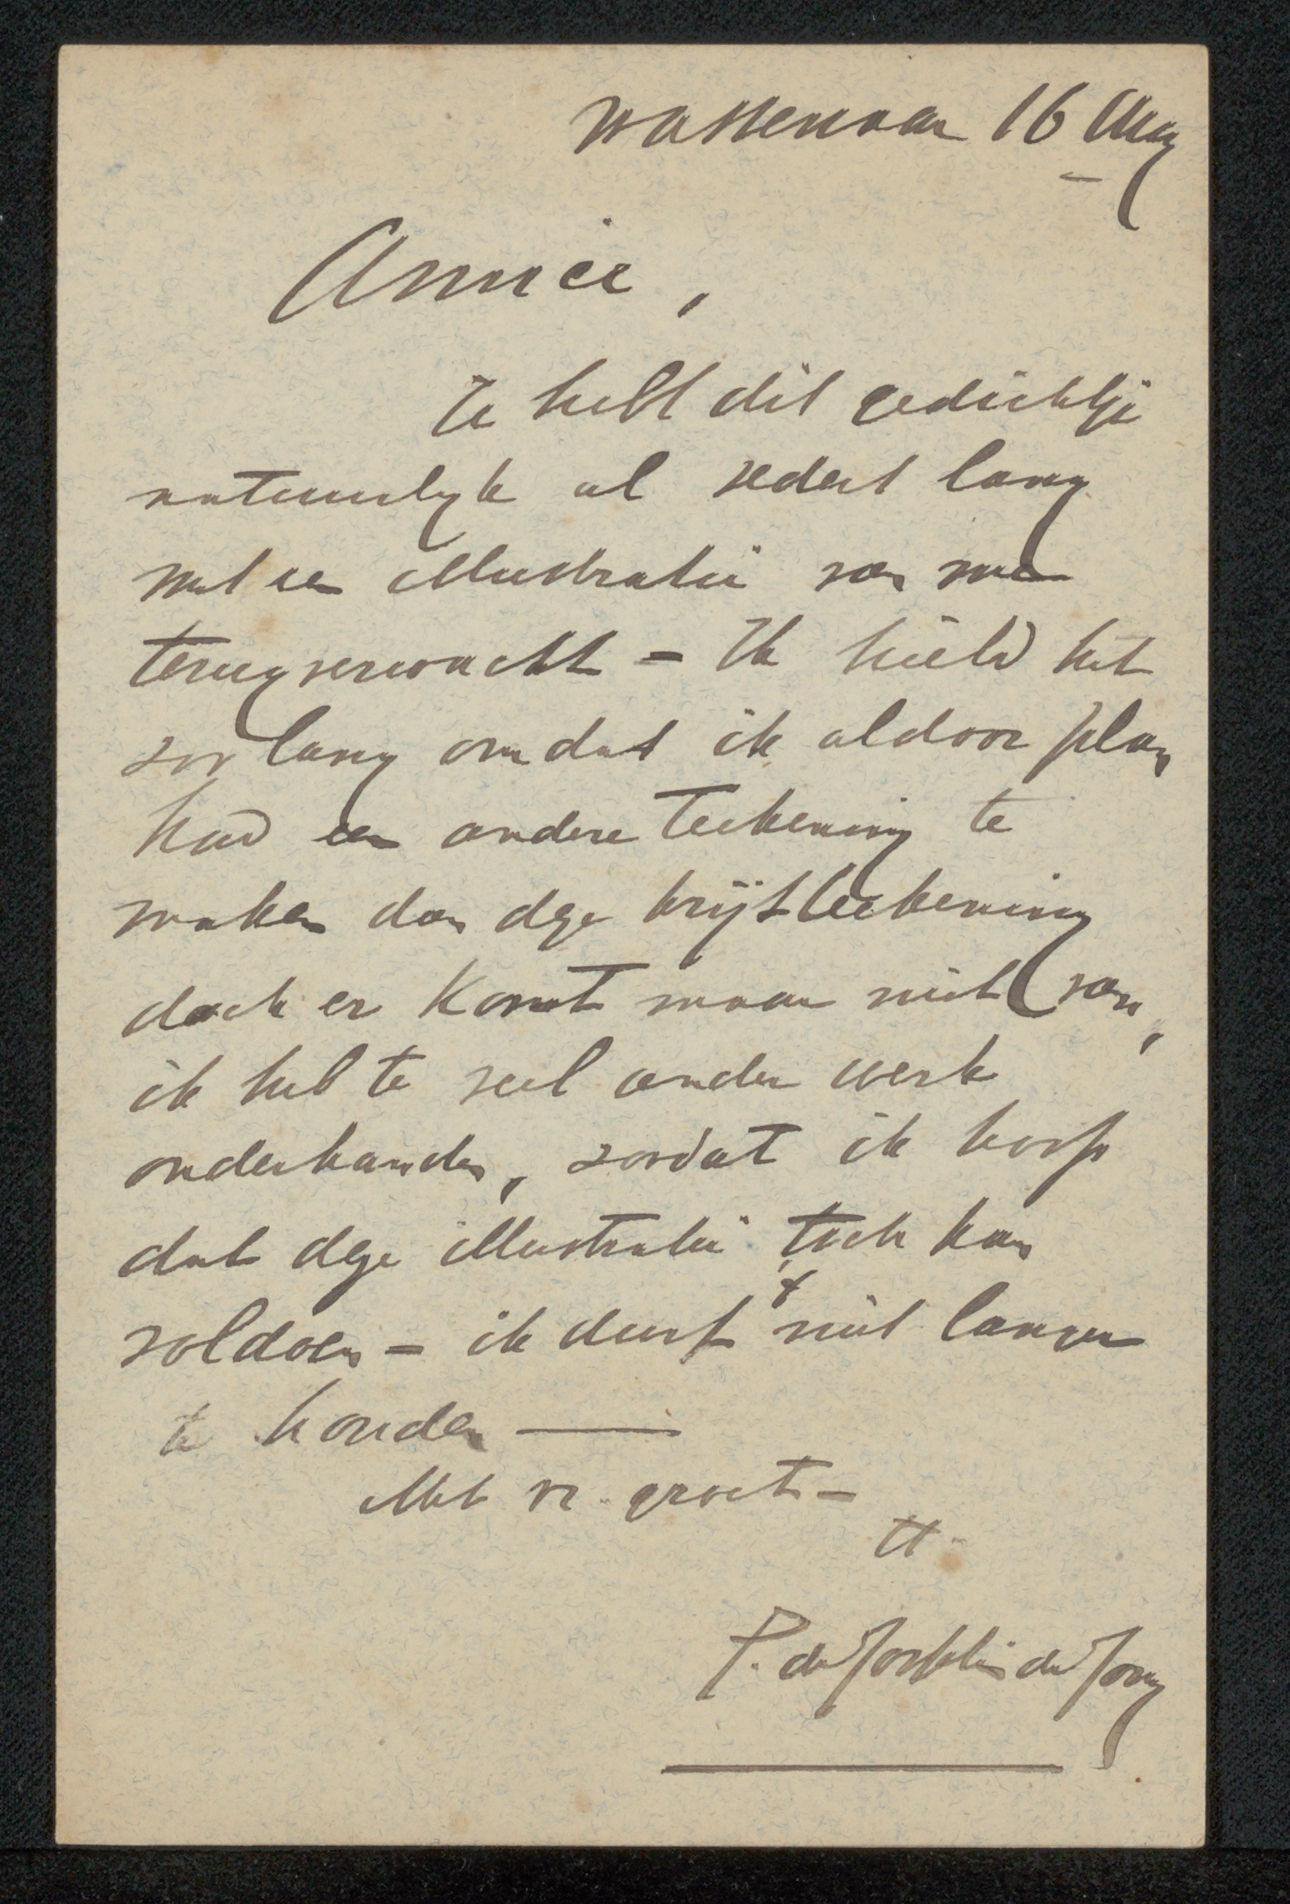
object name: letter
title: Brief aan Philip Zilcken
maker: pieter de josselin de jong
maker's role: draughtsman, painter, print maker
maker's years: 1861-1906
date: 1871-1906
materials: ink, paper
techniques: writing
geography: wassenaar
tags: rotterdam, amsterdam, herman robbers, philip zilcken, drawing, literature ~ arts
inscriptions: collector's mark: ‘RPK’